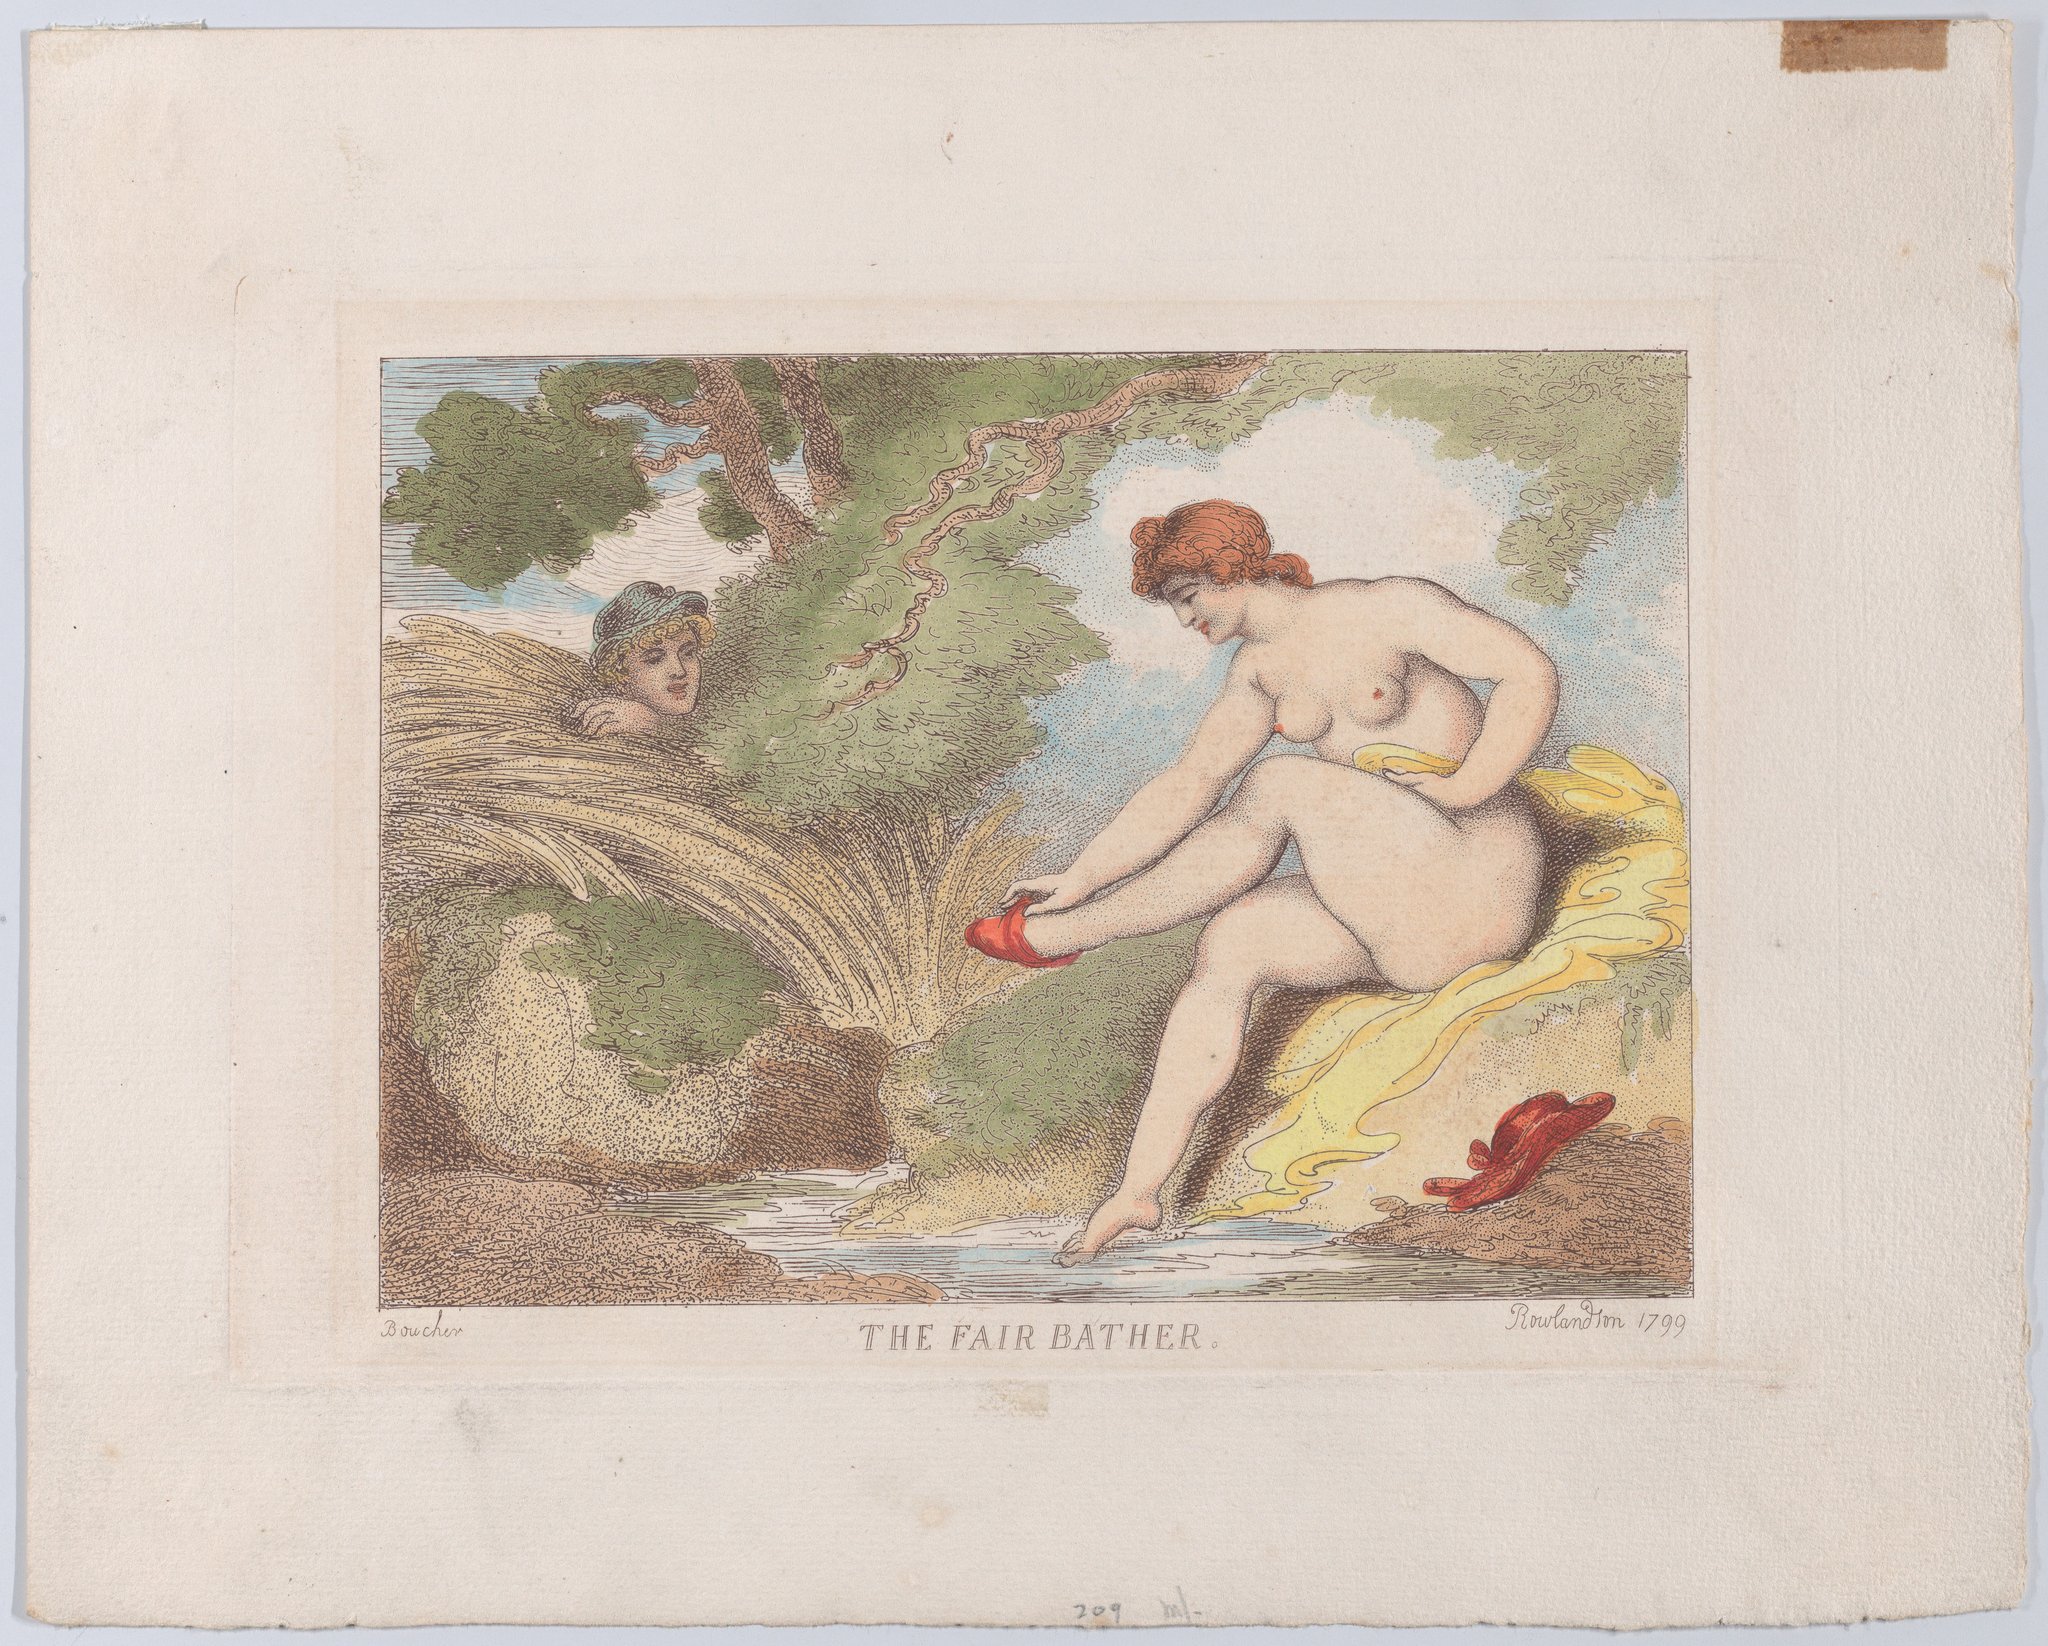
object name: print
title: The Fair Bather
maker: thomas rowlandson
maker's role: artist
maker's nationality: british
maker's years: 1757-1827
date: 1799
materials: ink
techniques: etching, printing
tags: men,female nudes